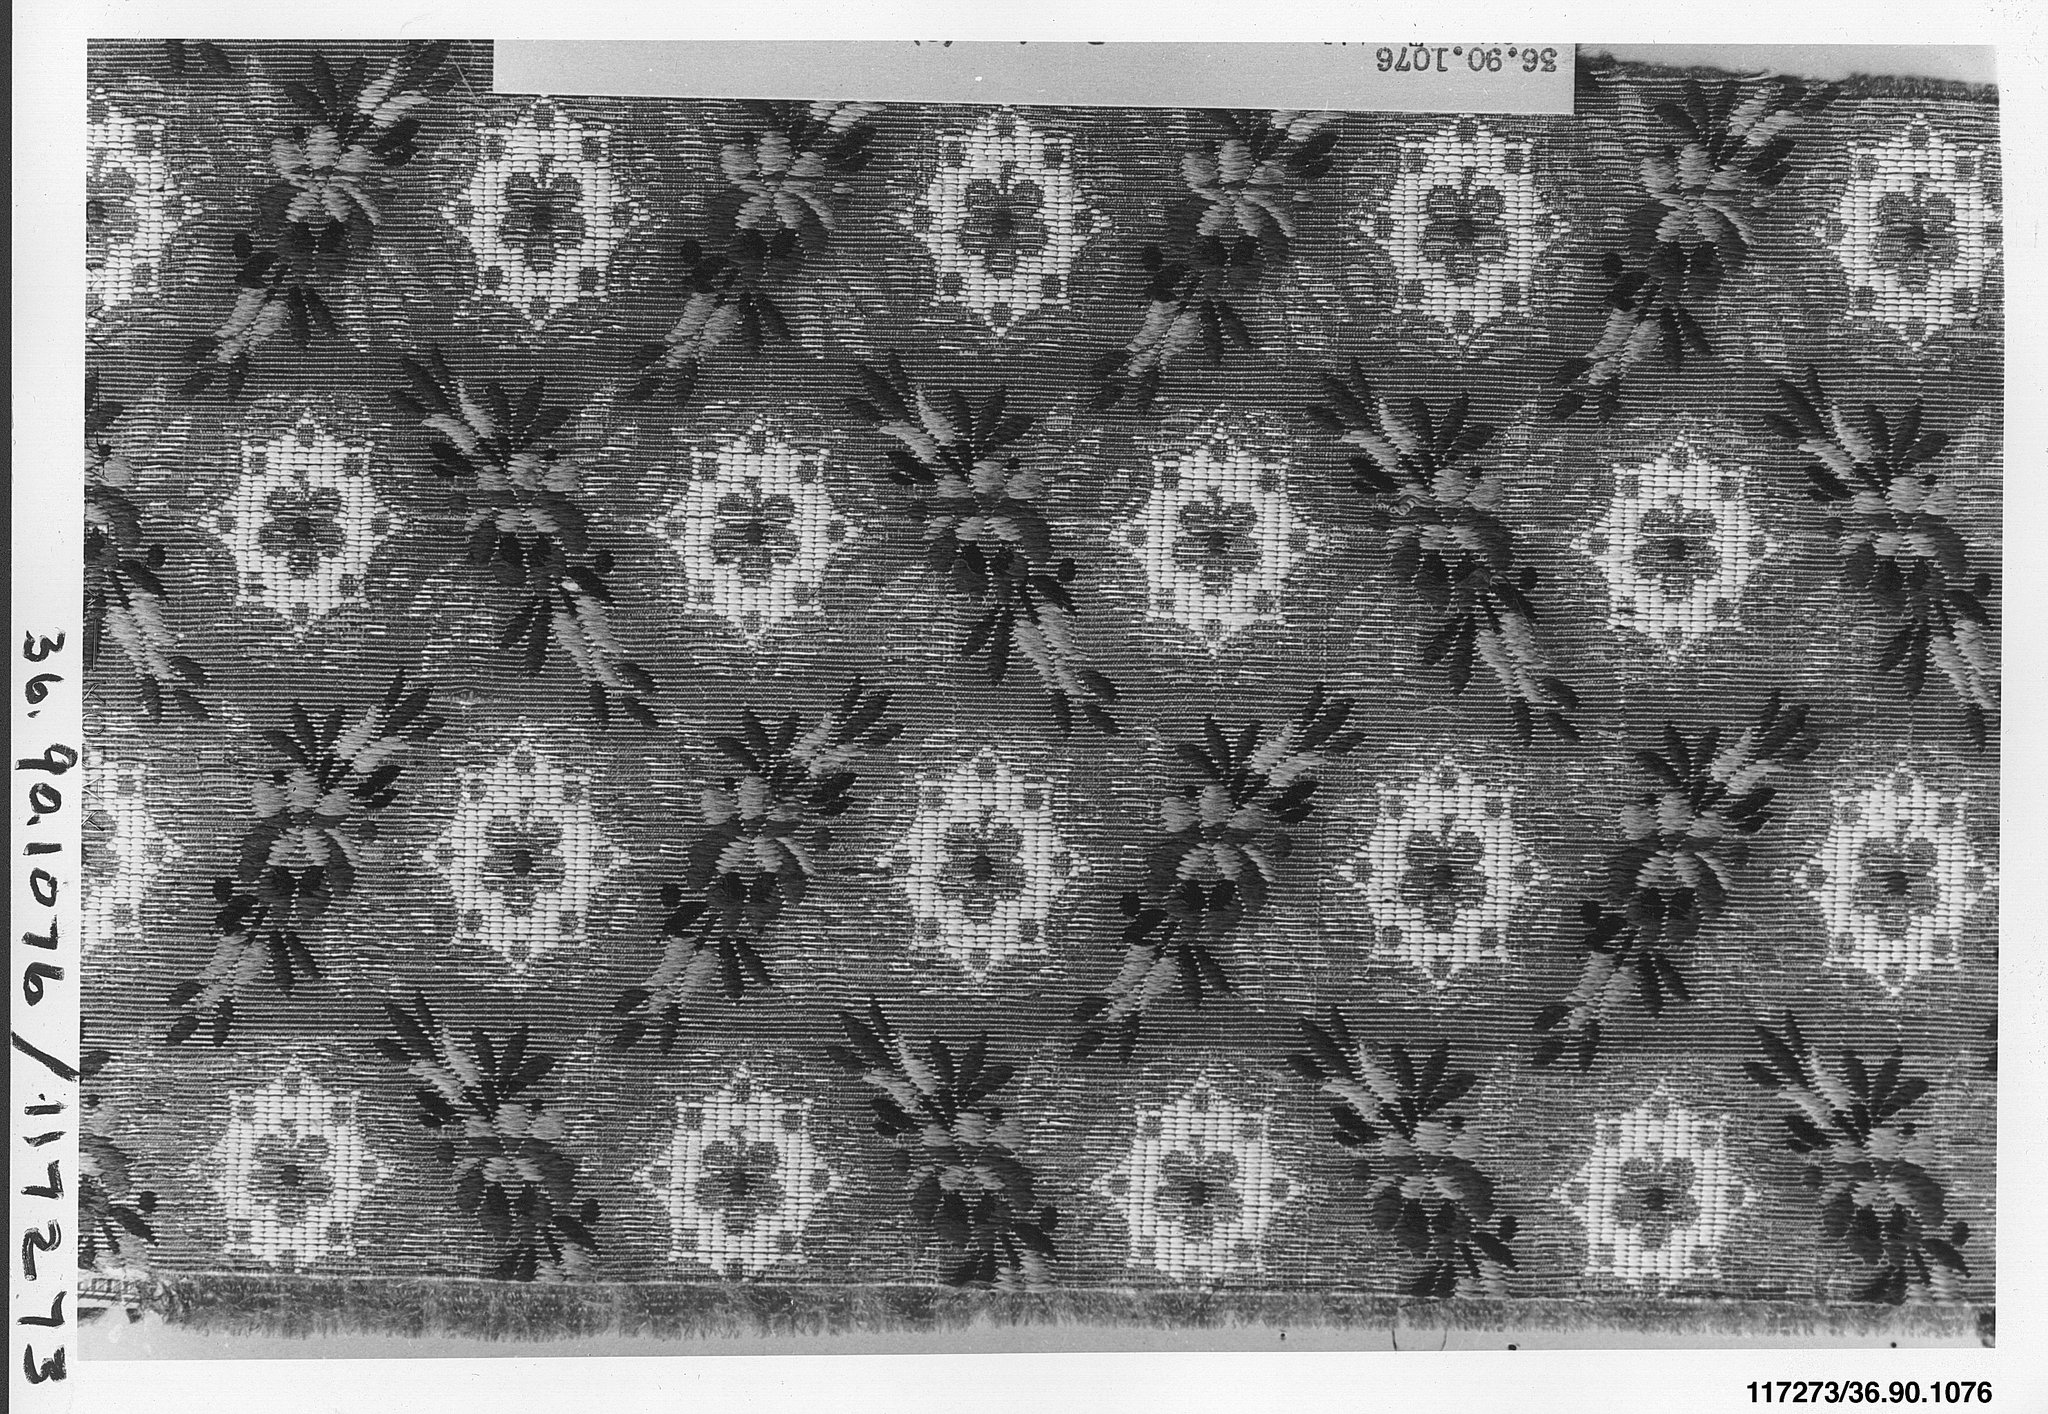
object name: piece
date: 1801-1900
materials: metal thread, silk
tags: flowers,leaves